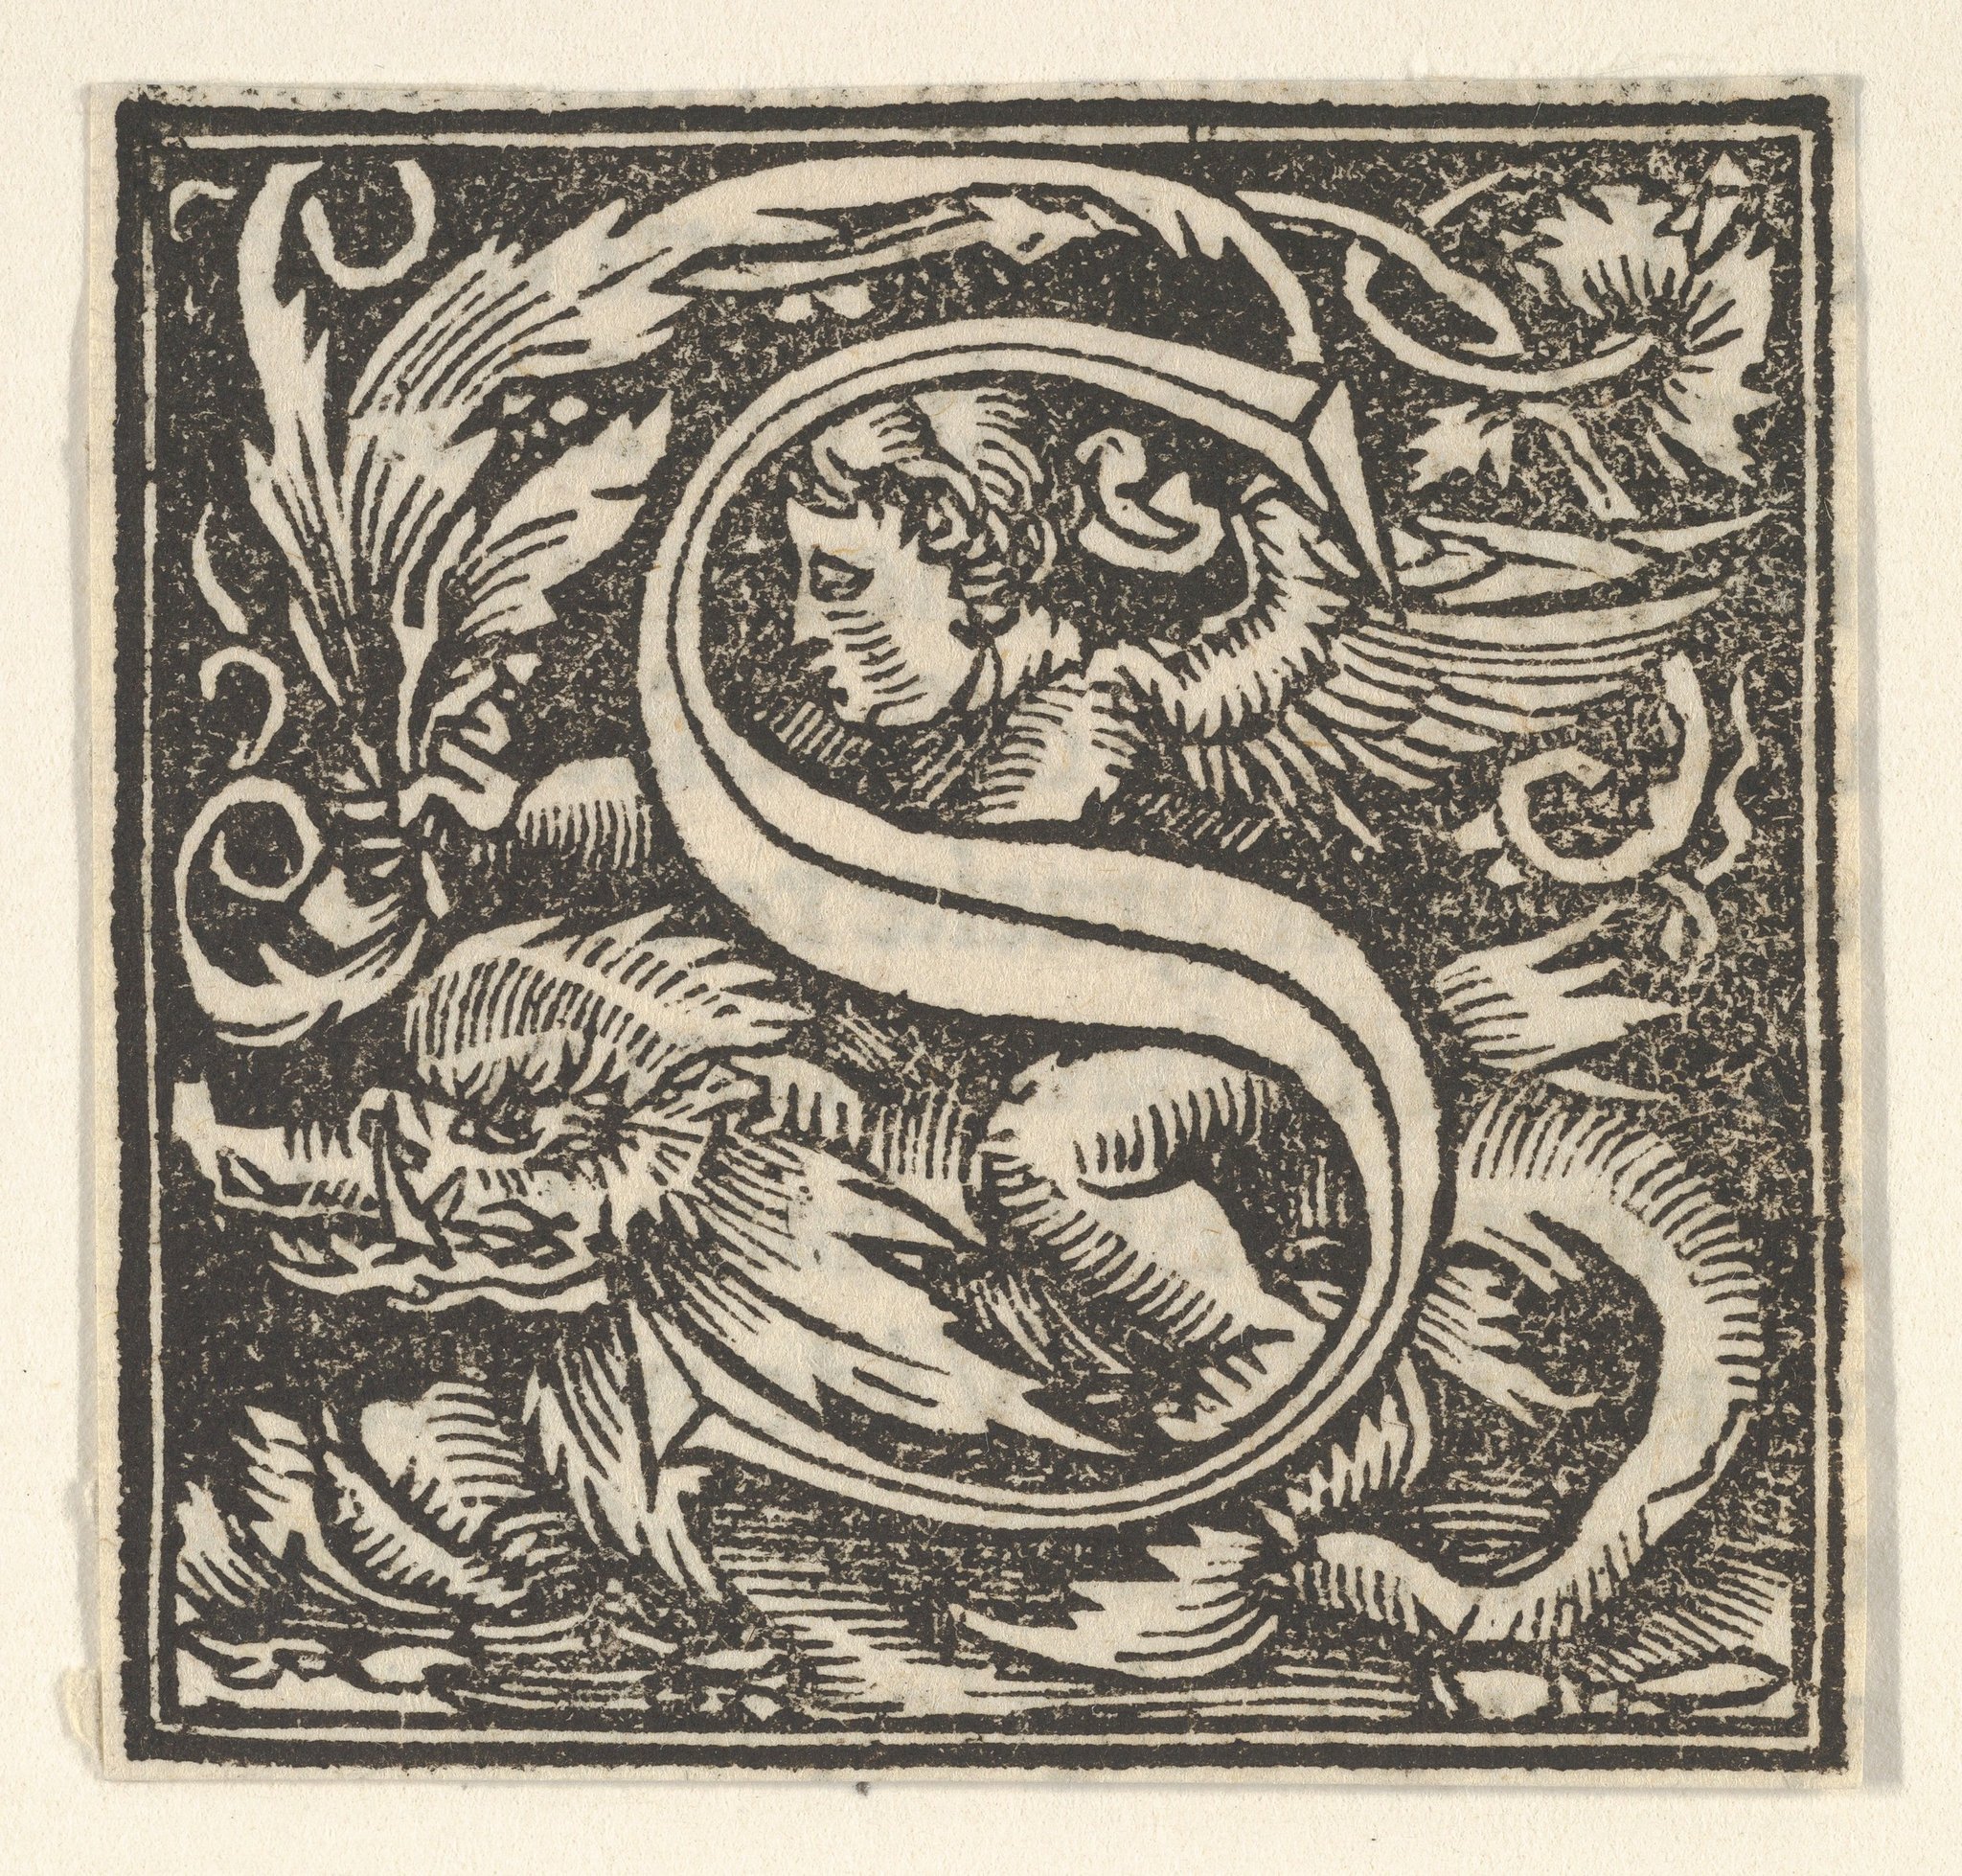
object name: print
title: Initial letter S with putto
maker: heinrich vogtherr the elder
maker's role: artist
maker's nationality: german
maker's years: 1538-1540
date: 1538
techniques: woodcut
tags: ornament,dragons,putti